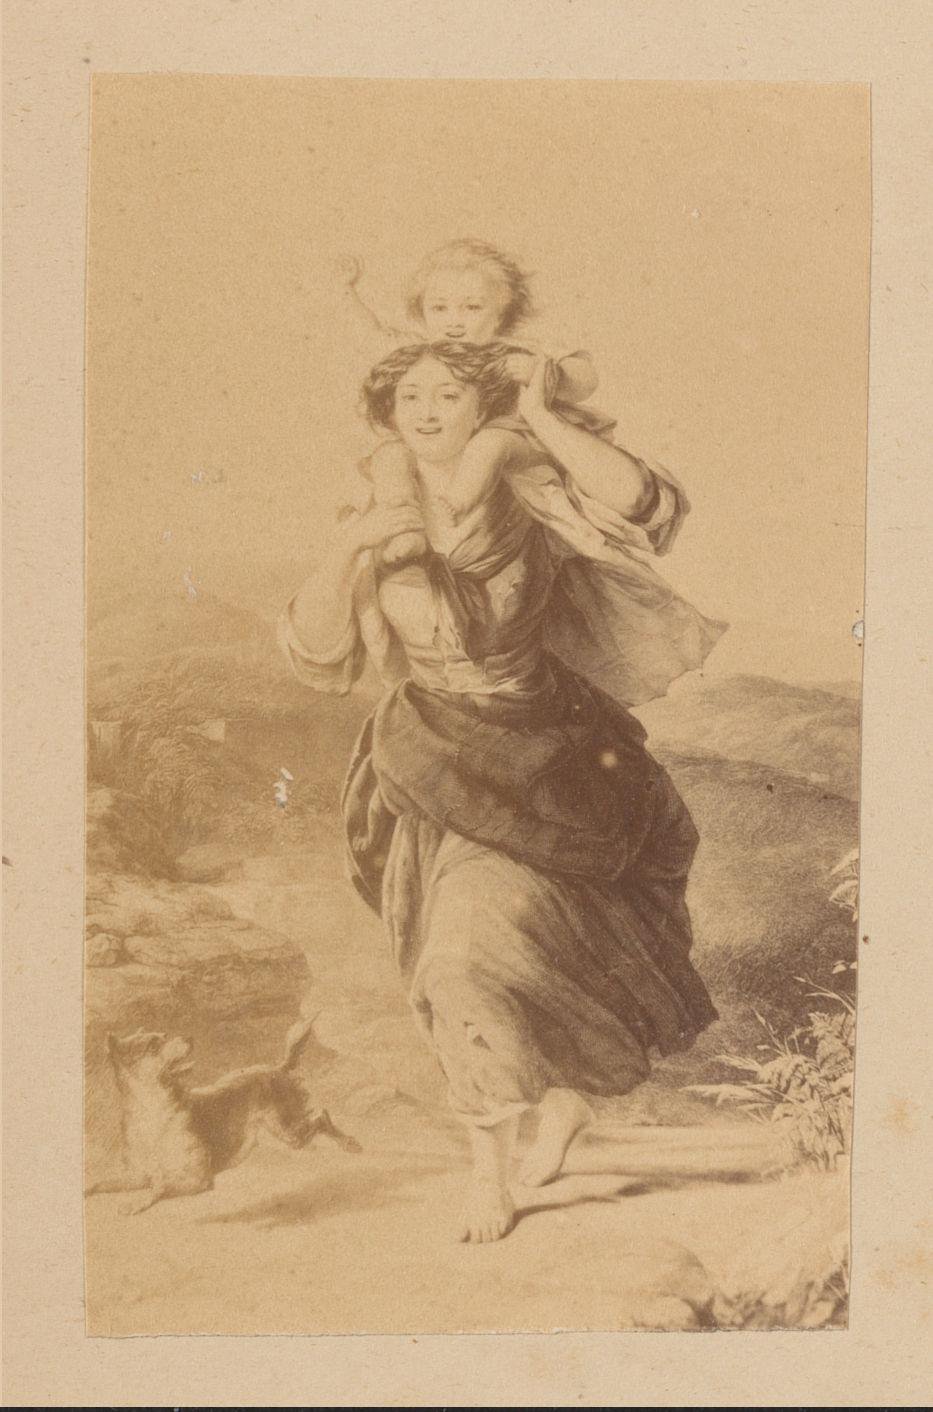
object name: photograph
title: Fotoreproductie van een schilderij met een rennende vrouw met een kind op haar schouders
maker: Anonymous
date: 1875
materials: photographic support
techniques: albumen print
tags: mother and baby or young child